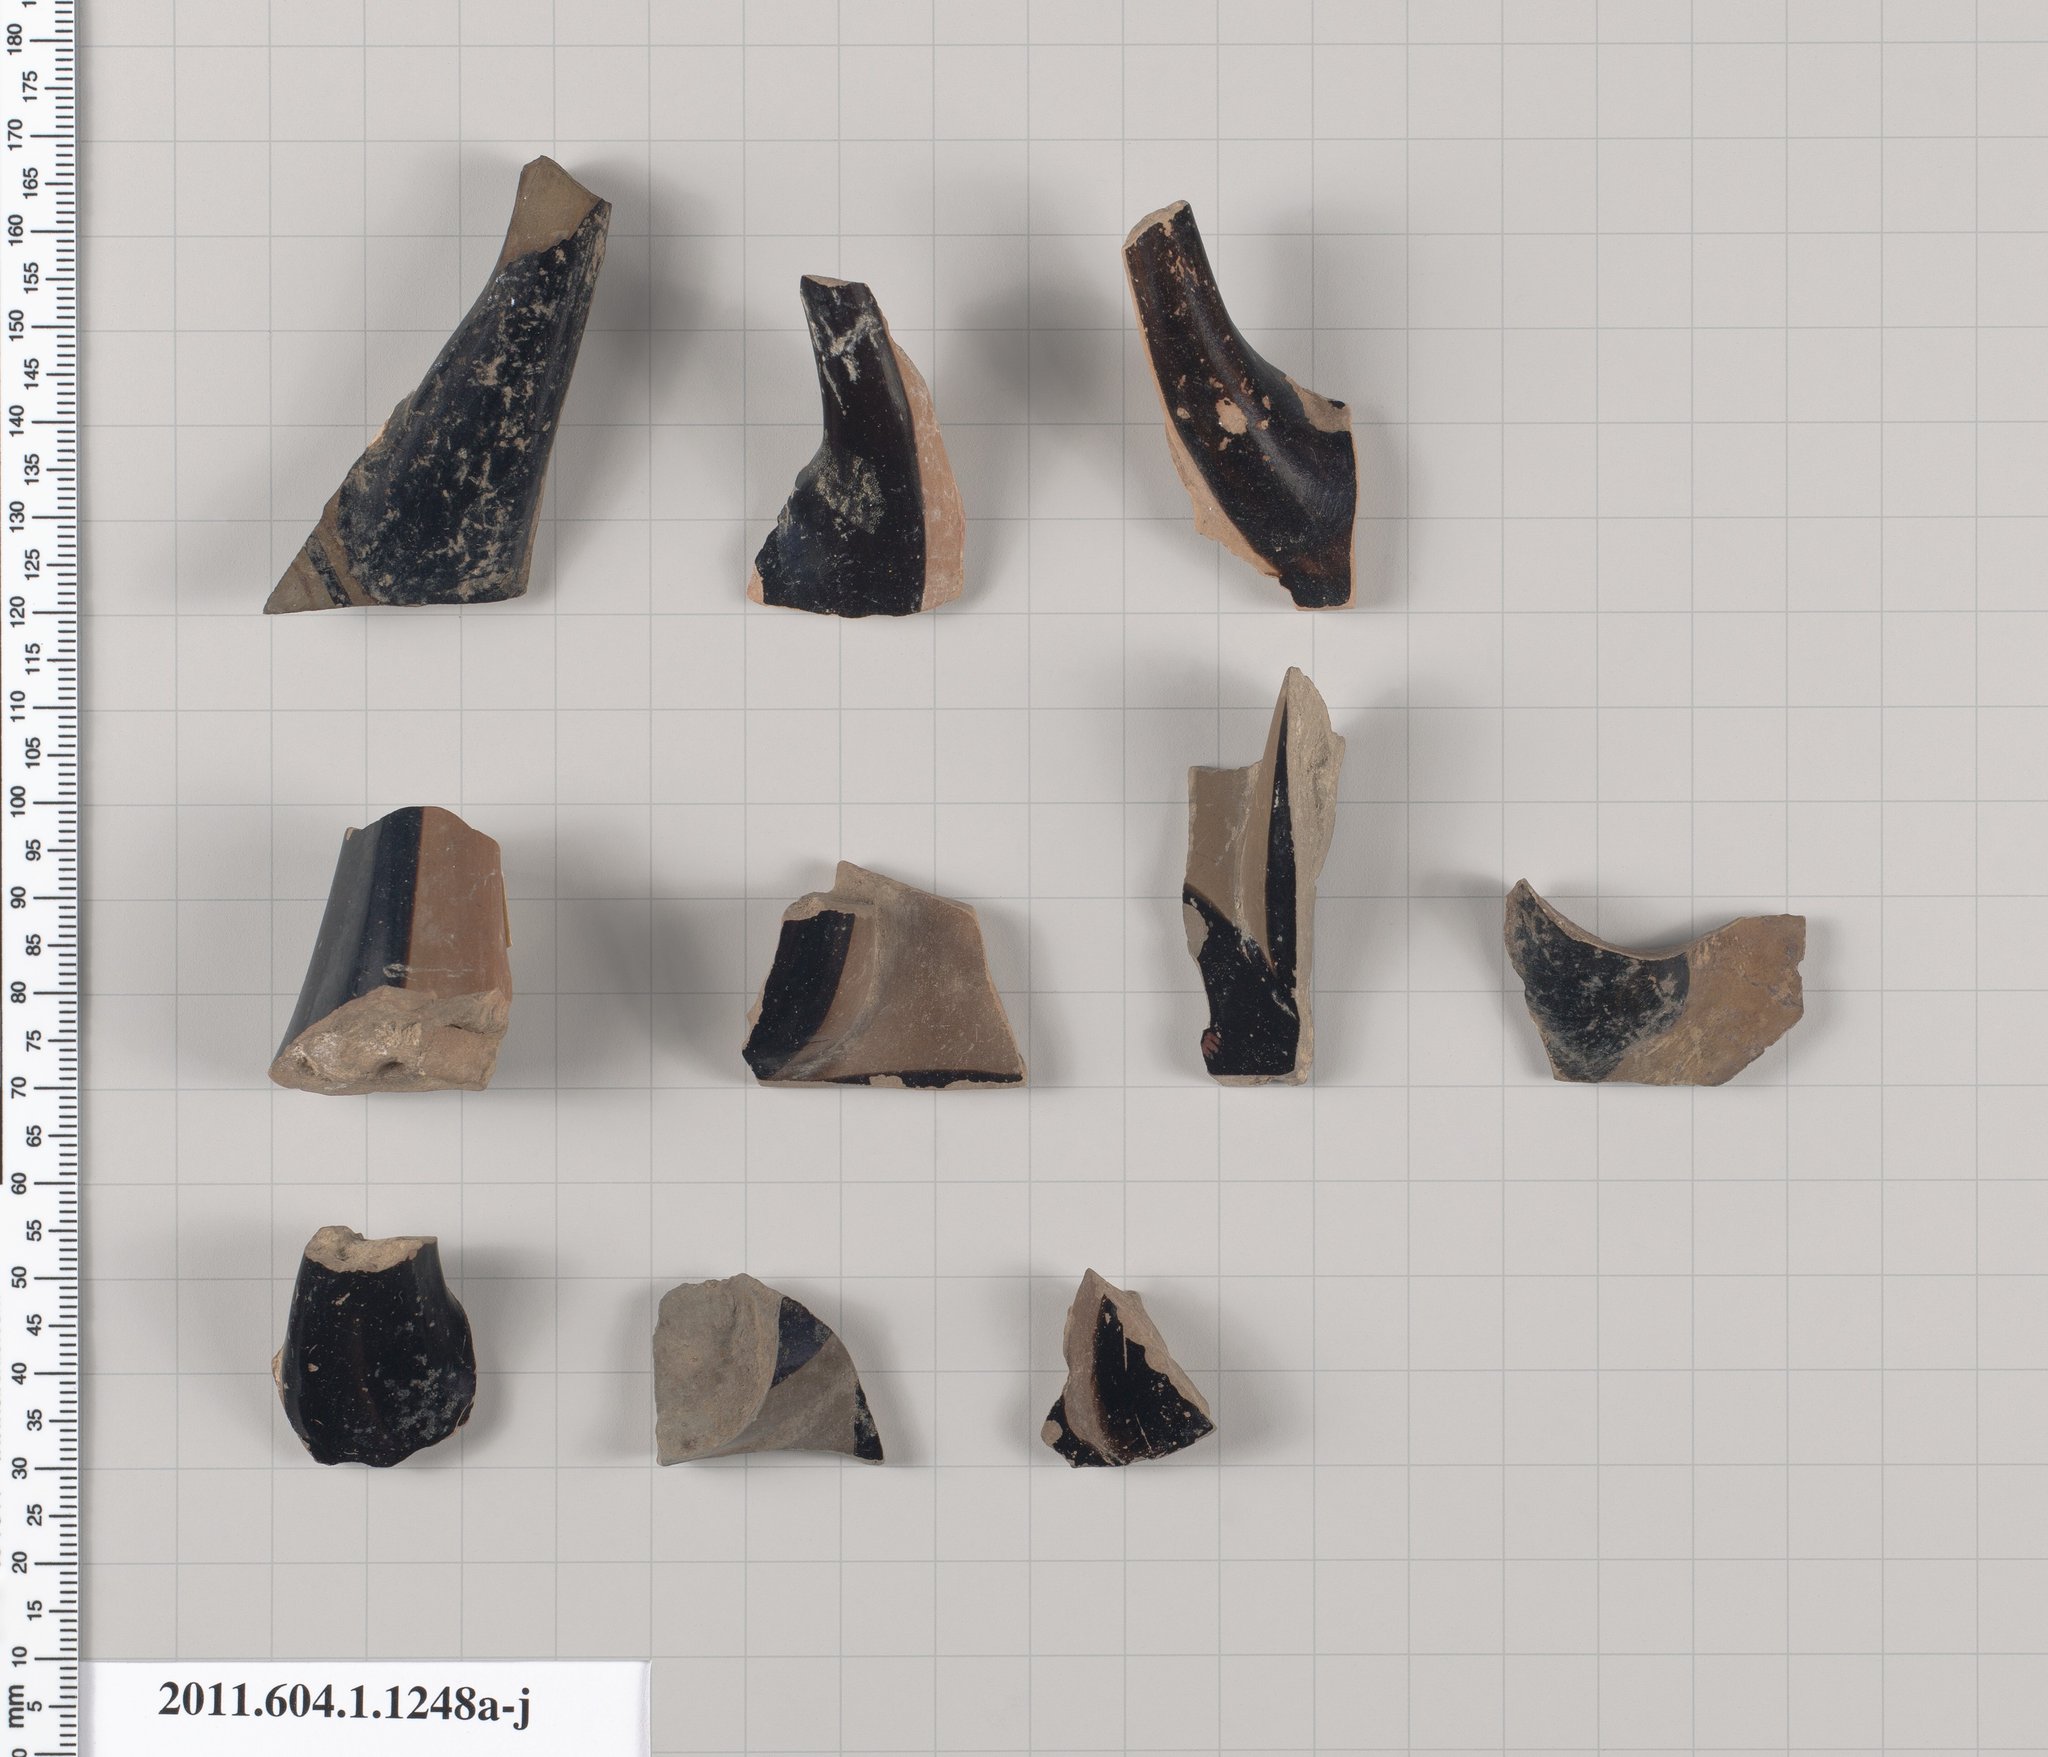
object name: kylix fragment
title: Terracotta fragments of kylikes (drinking cups)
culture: greek, attic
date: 500-401 BCE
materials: terracotta